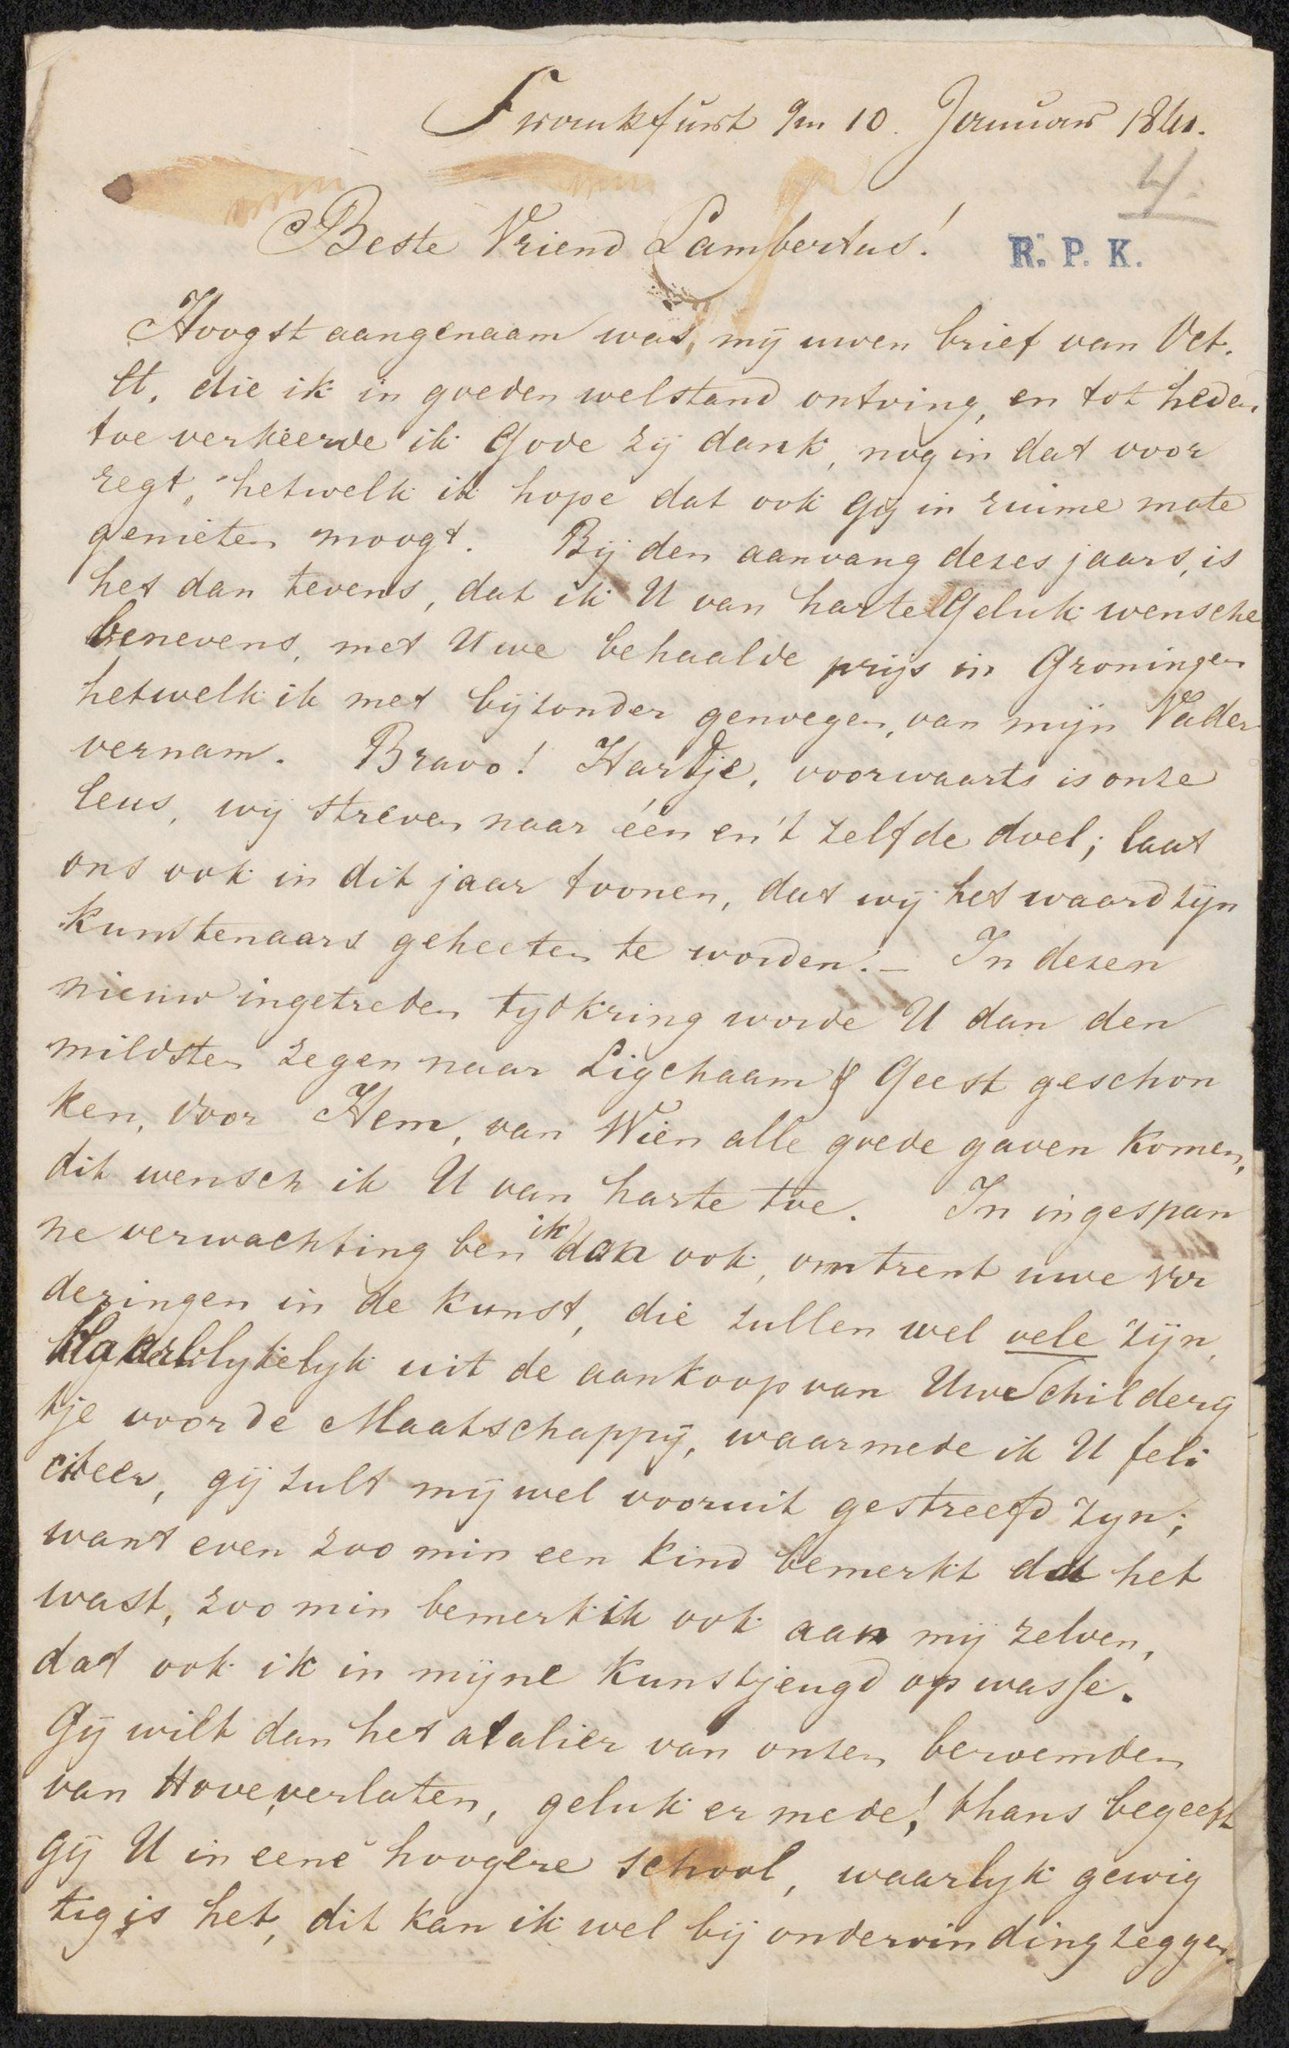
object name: letter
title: Brief aan Lambertus Hardenberg (1822-1900)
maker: everhardus koster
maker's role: draughtsman, painter, print maker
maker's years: 1817-1892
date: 1841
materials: ink, paper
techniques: pen, writing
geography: frankfurt am main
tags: bartholomeus johannes van hove, lambertus hardenberg (1822-1900), distribution of awards ~ art contest, family life, painting (including book-illumination, miniature-painting), workshop, studio of the artist (in general), exhibition ~ art, the hague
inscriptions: seal, collector's mark: Lugt 2233